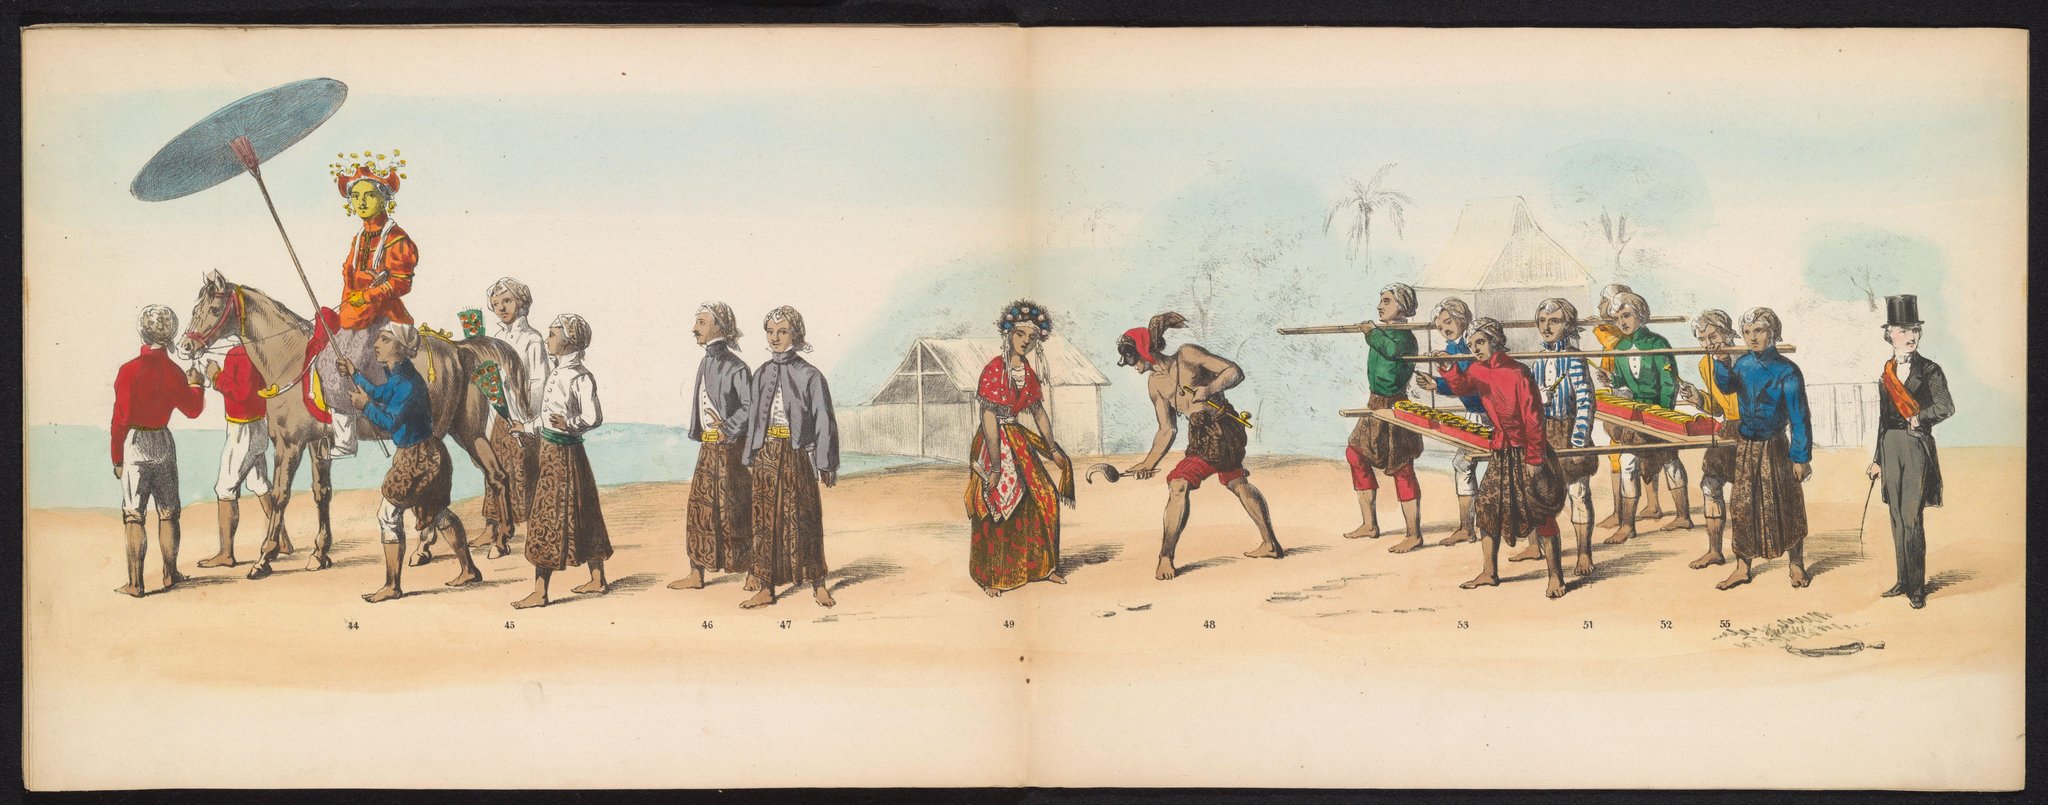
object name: print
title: Maskerade van de Delftse studenten, 1857 (plaat 6)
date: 1857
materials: paper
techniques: hand coloring, lithograph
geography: the hague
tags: students' pageant, costumes used in pageants, delft, dutch east indies, the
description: Gekostumeerde optocht van de studenten van de Koninklijke Akademie te Delft op 5 mei 1857. De optocht verbeeldt de Garebeg optocht van de sultan van Djokjakarta plus verschillende karakteristieke types uit de Indonesische archipel. Zesde plaat met de groepen genummerd 44-55. Onderdeel van de serie van acht en een half aanelkaar geplakte bladen.